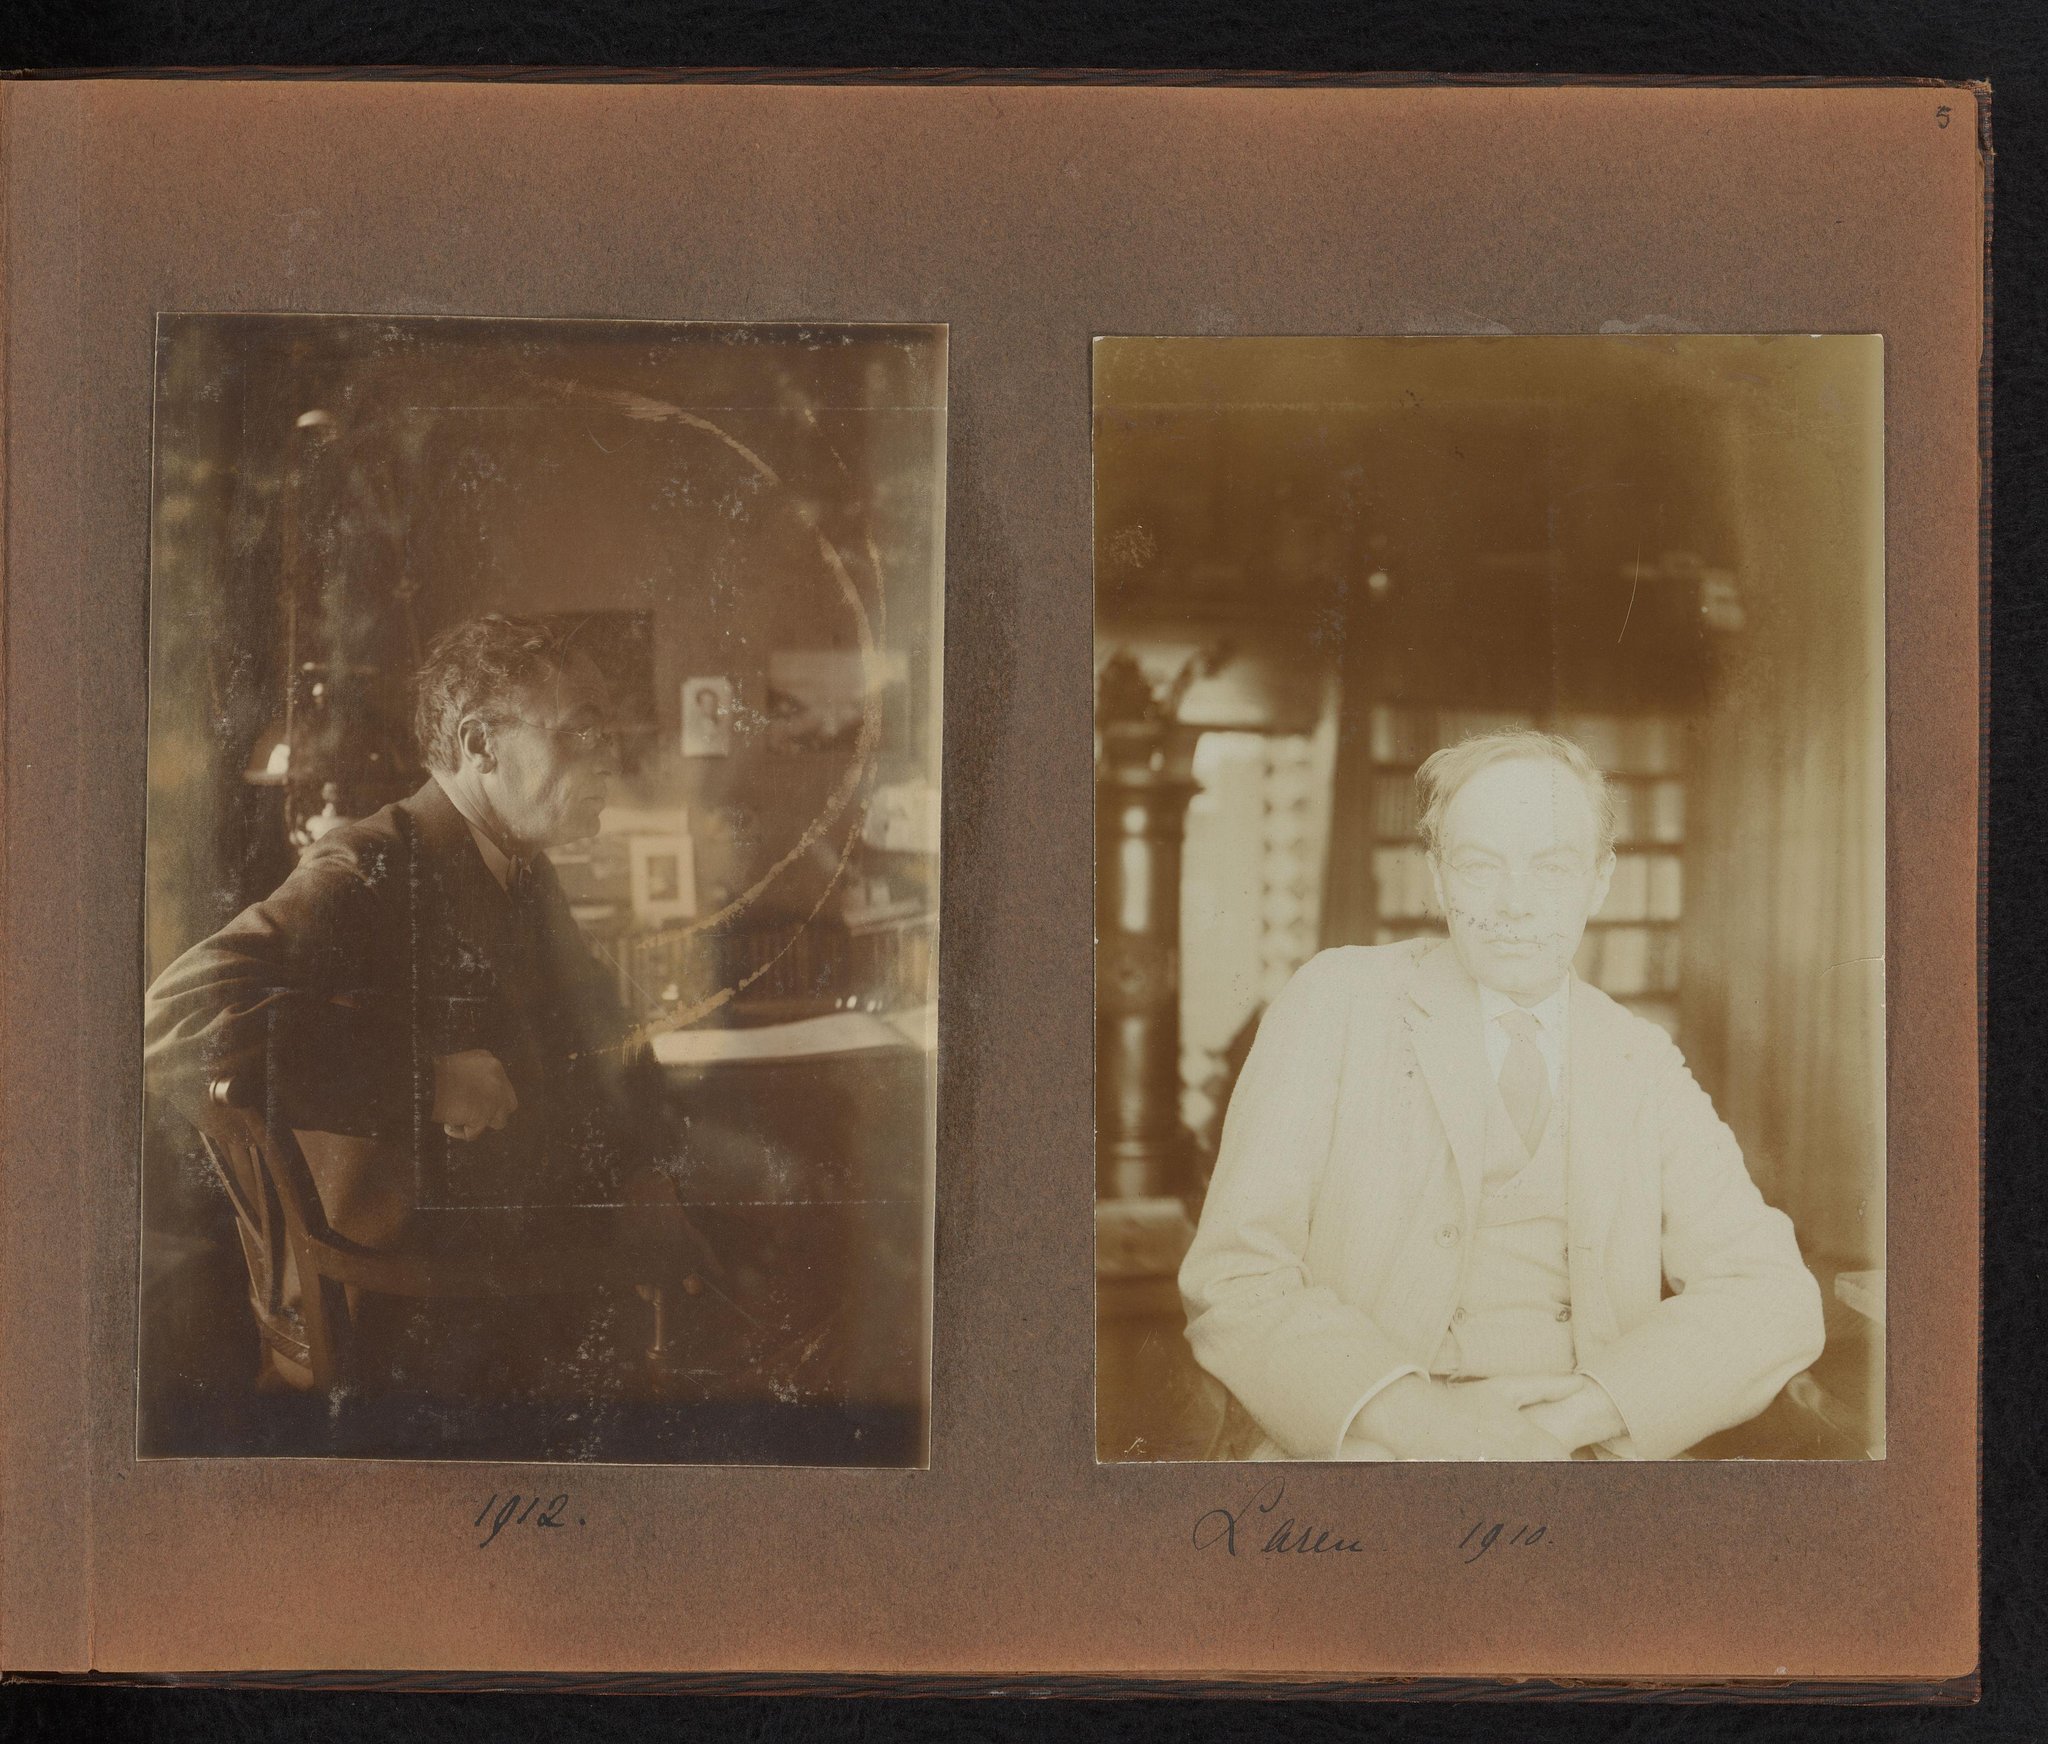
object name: photograph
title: Bladzijde uit het fotoalbum van de familie Diepenbrock met 2 foto's van Alphons Diepenbrock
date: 1910-1912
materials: cardboard, photographic support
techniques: photography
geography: netherlands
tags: amsterdam, alphons diepenbrock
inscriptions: inscription: ‘1912. Laren 1910’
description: Bruin albumblad 5 van familiealbum van Alphons Diepenbrock.